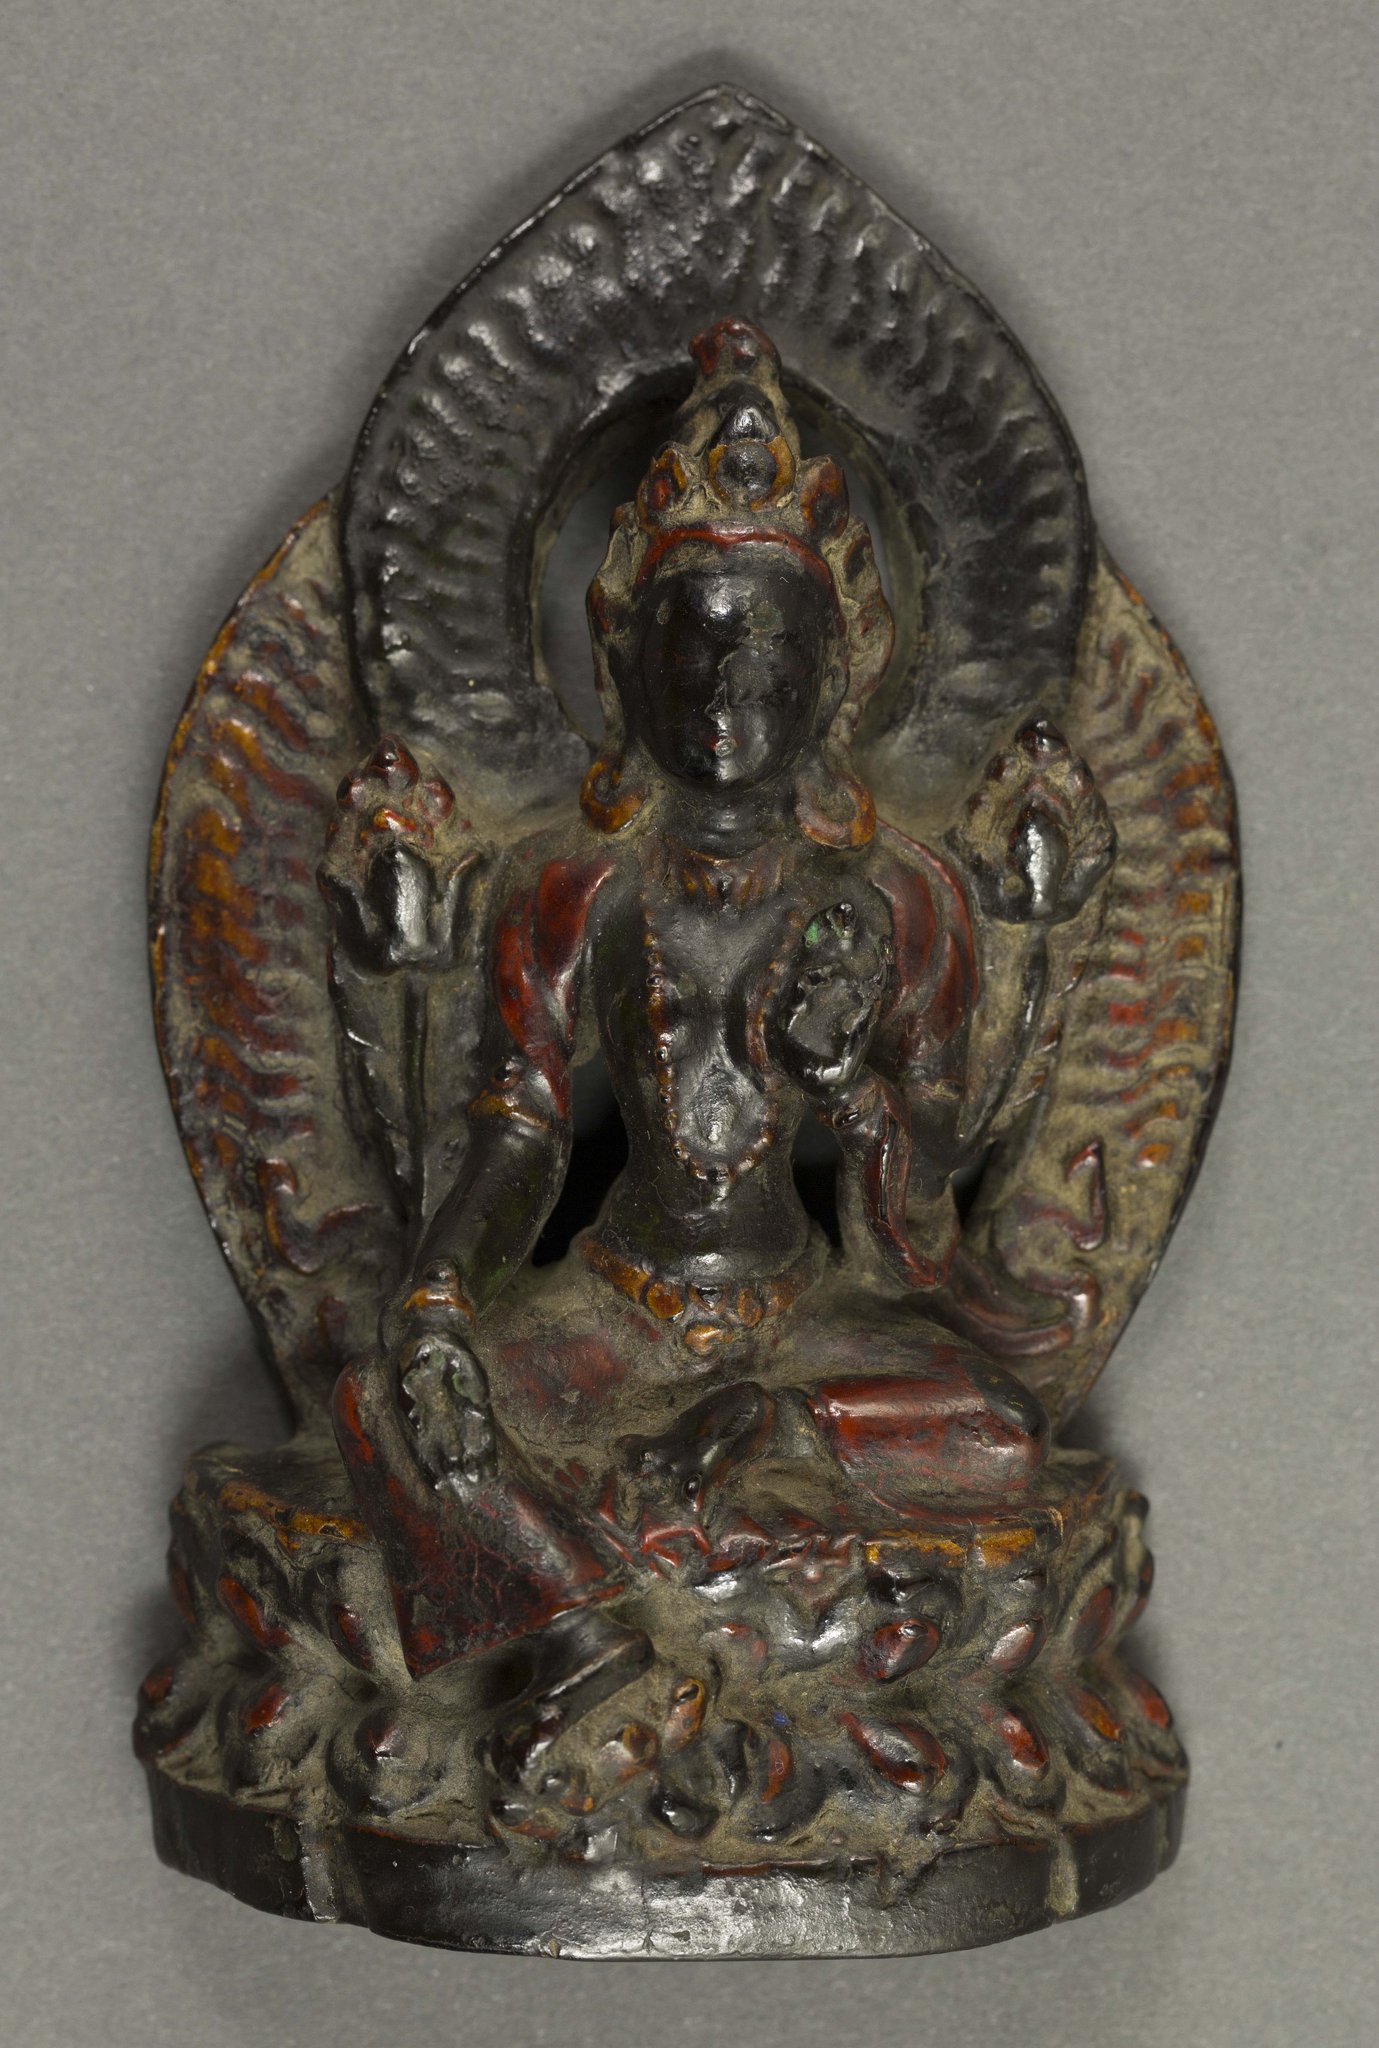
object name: figurine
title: Seated Tara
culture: nepali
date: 1601-1700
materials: wood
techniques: polychrome